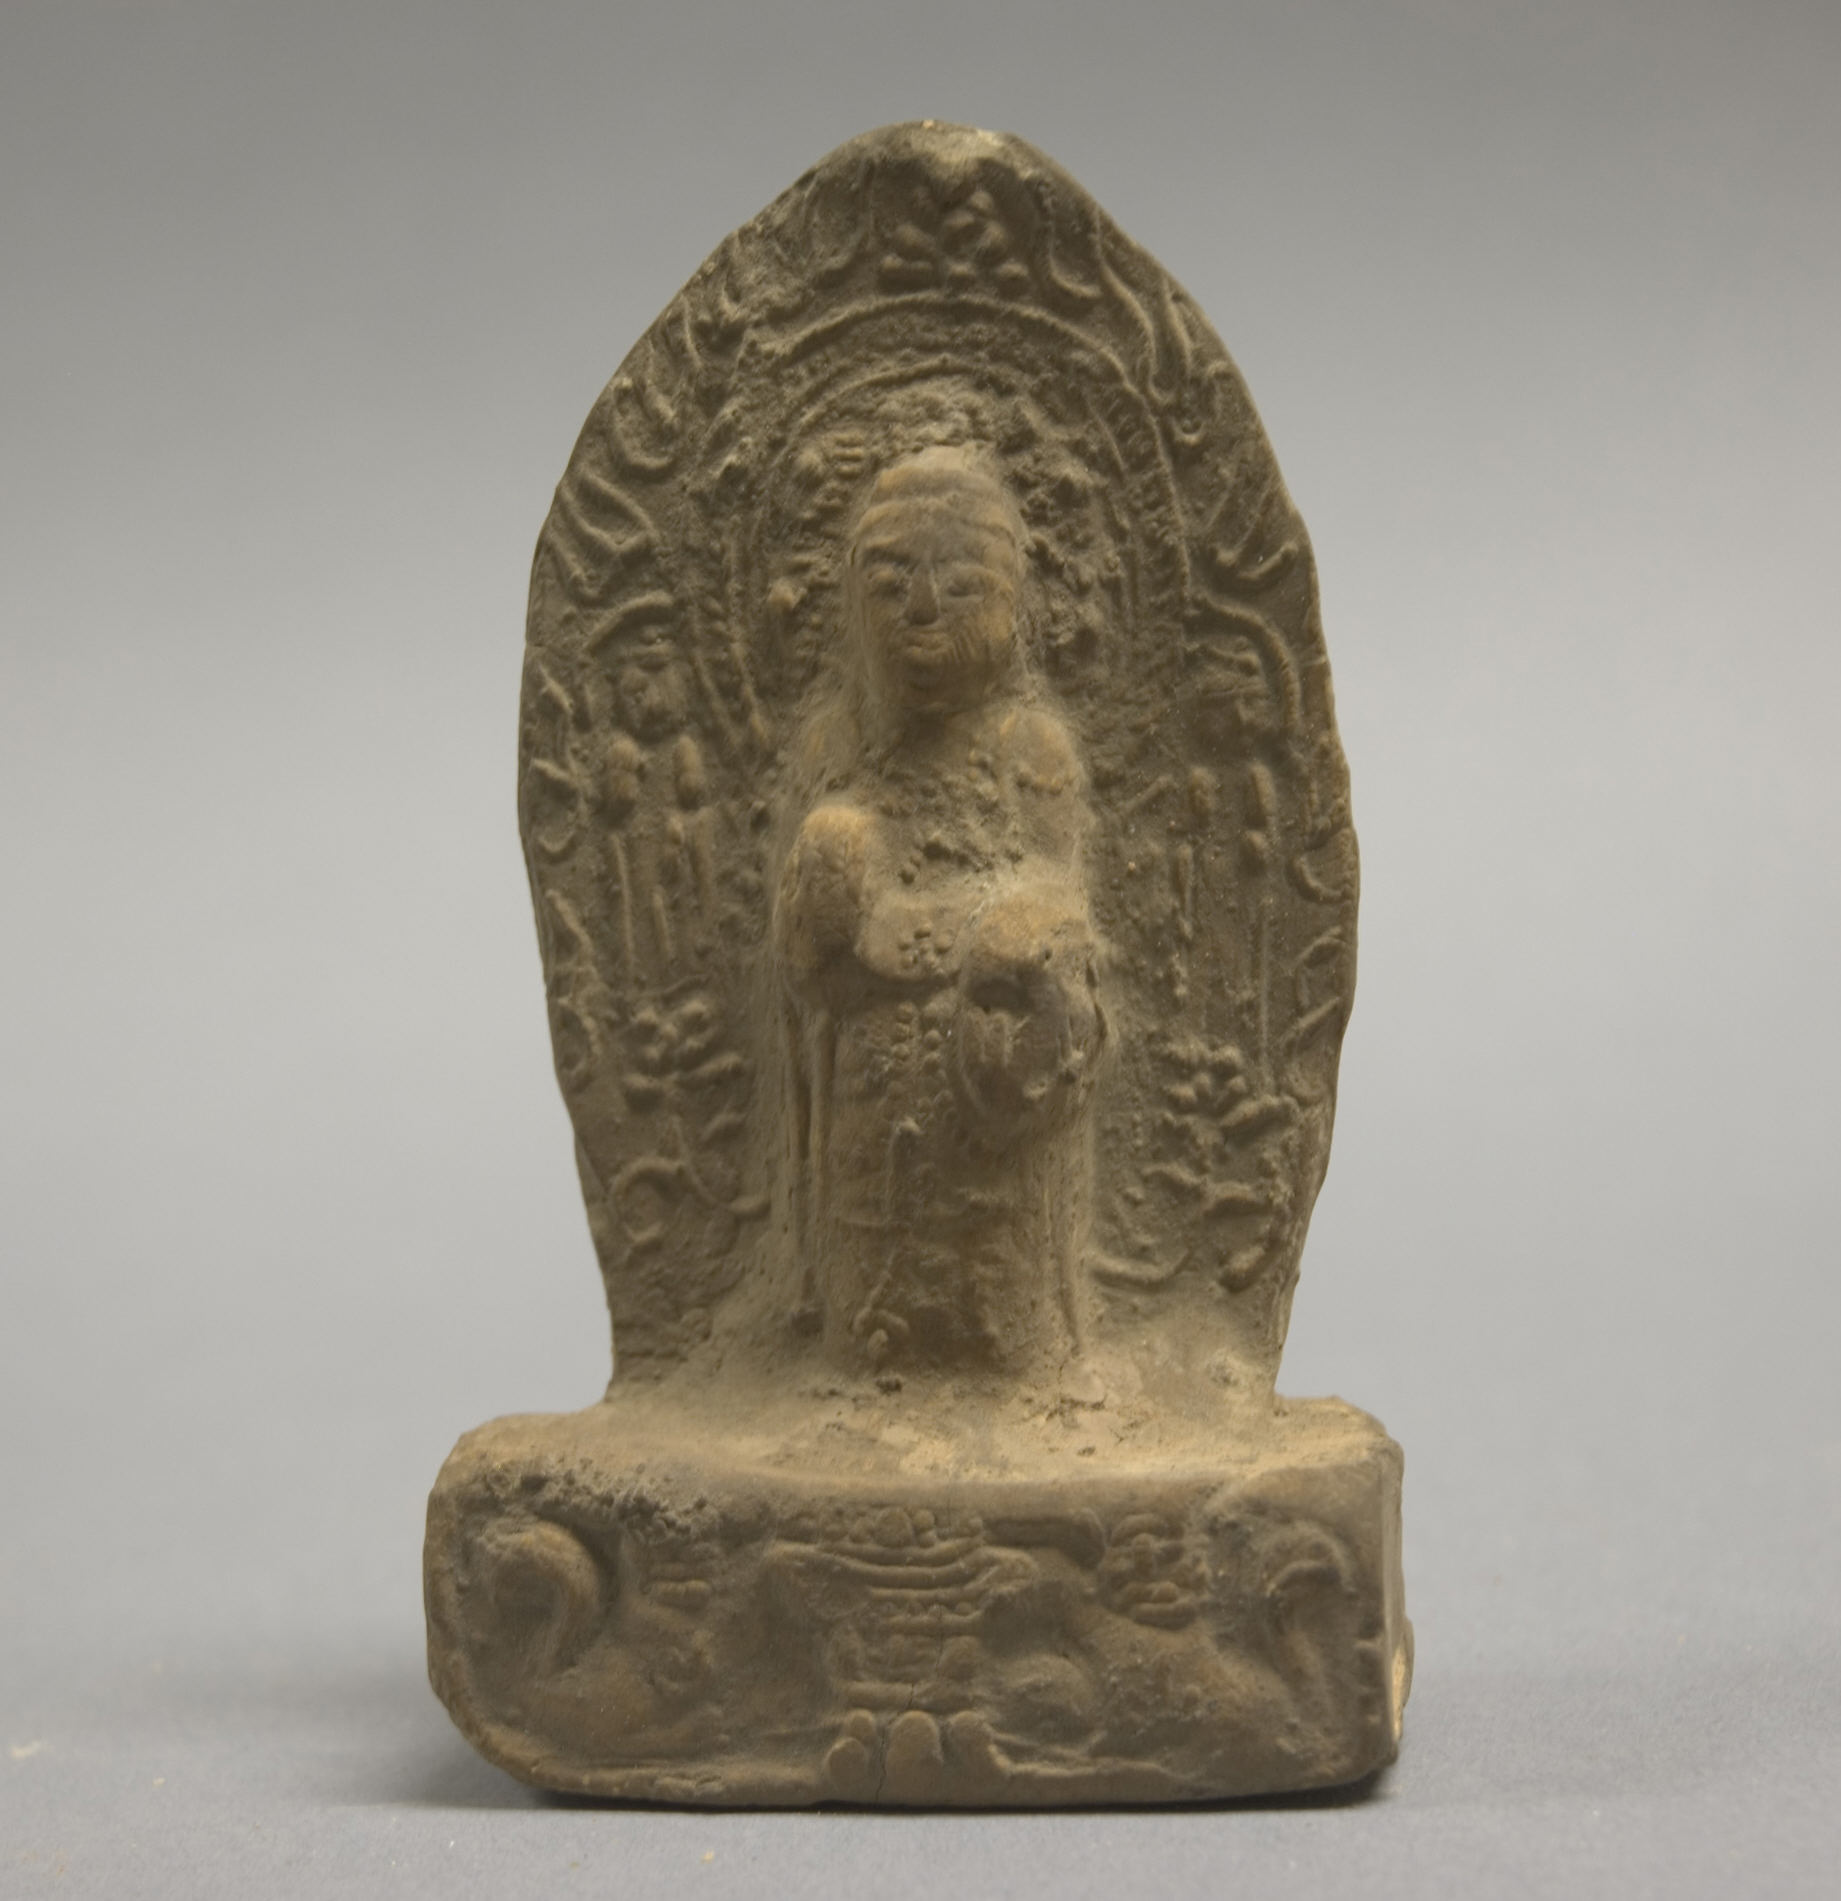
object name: stele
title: Stele with Buddha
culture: chinese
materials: earthenware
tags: buddhism,bodhisattvas